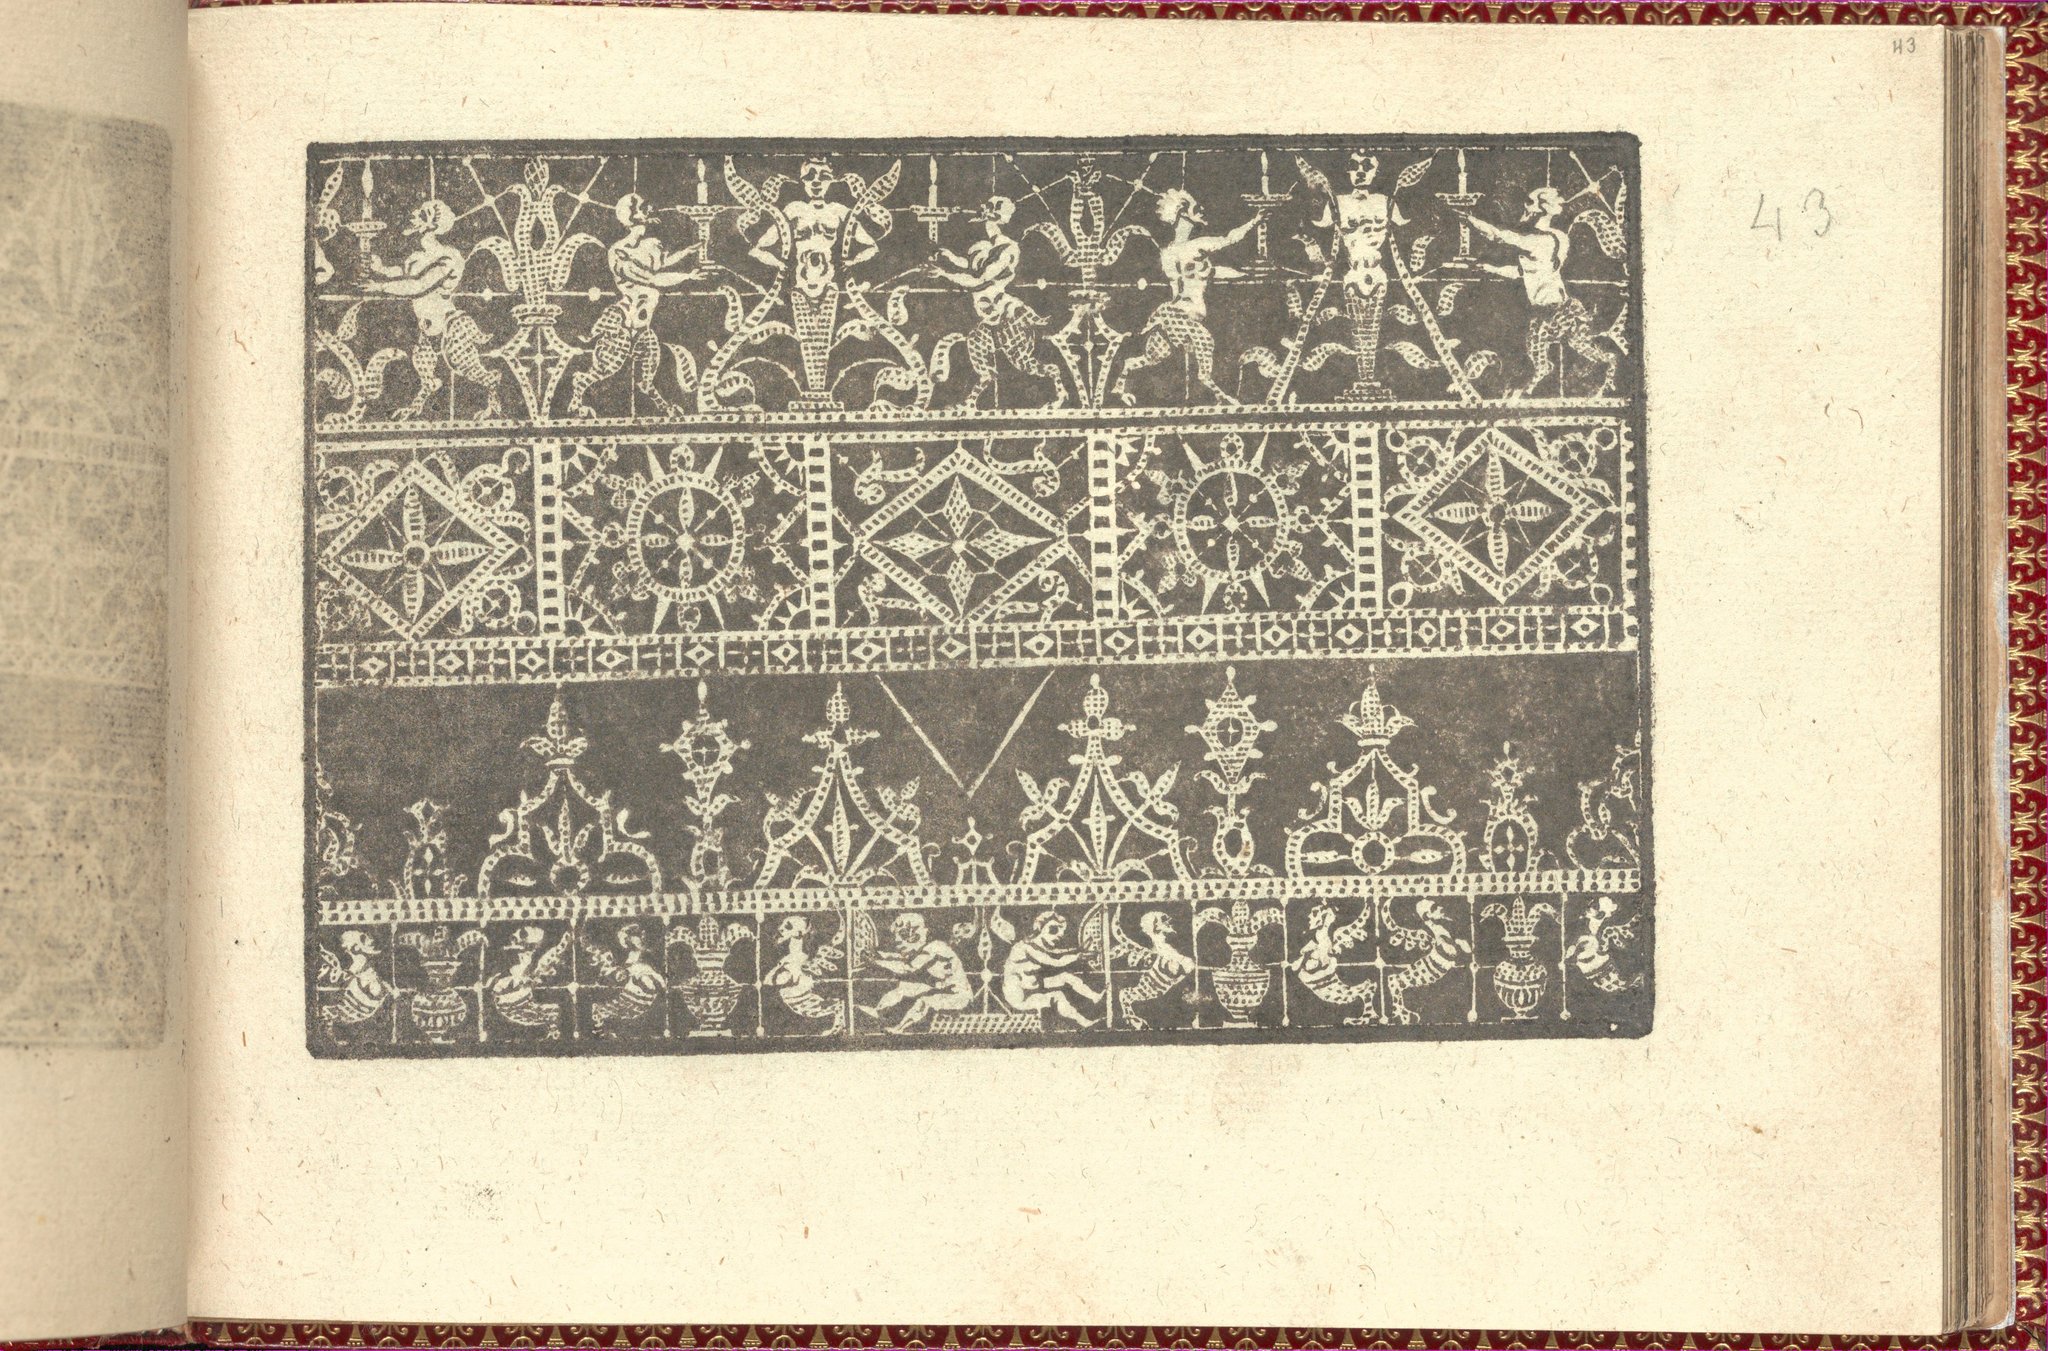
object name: book print ornament architecture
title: Corona delle Nobili et Virtuose Donne: Libro I-IV, page 43 (recto)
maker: cesare vecellio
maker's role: publisher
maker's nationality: italian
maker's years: 1521-1601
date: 1601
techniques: woodcut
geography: italy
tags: ornament